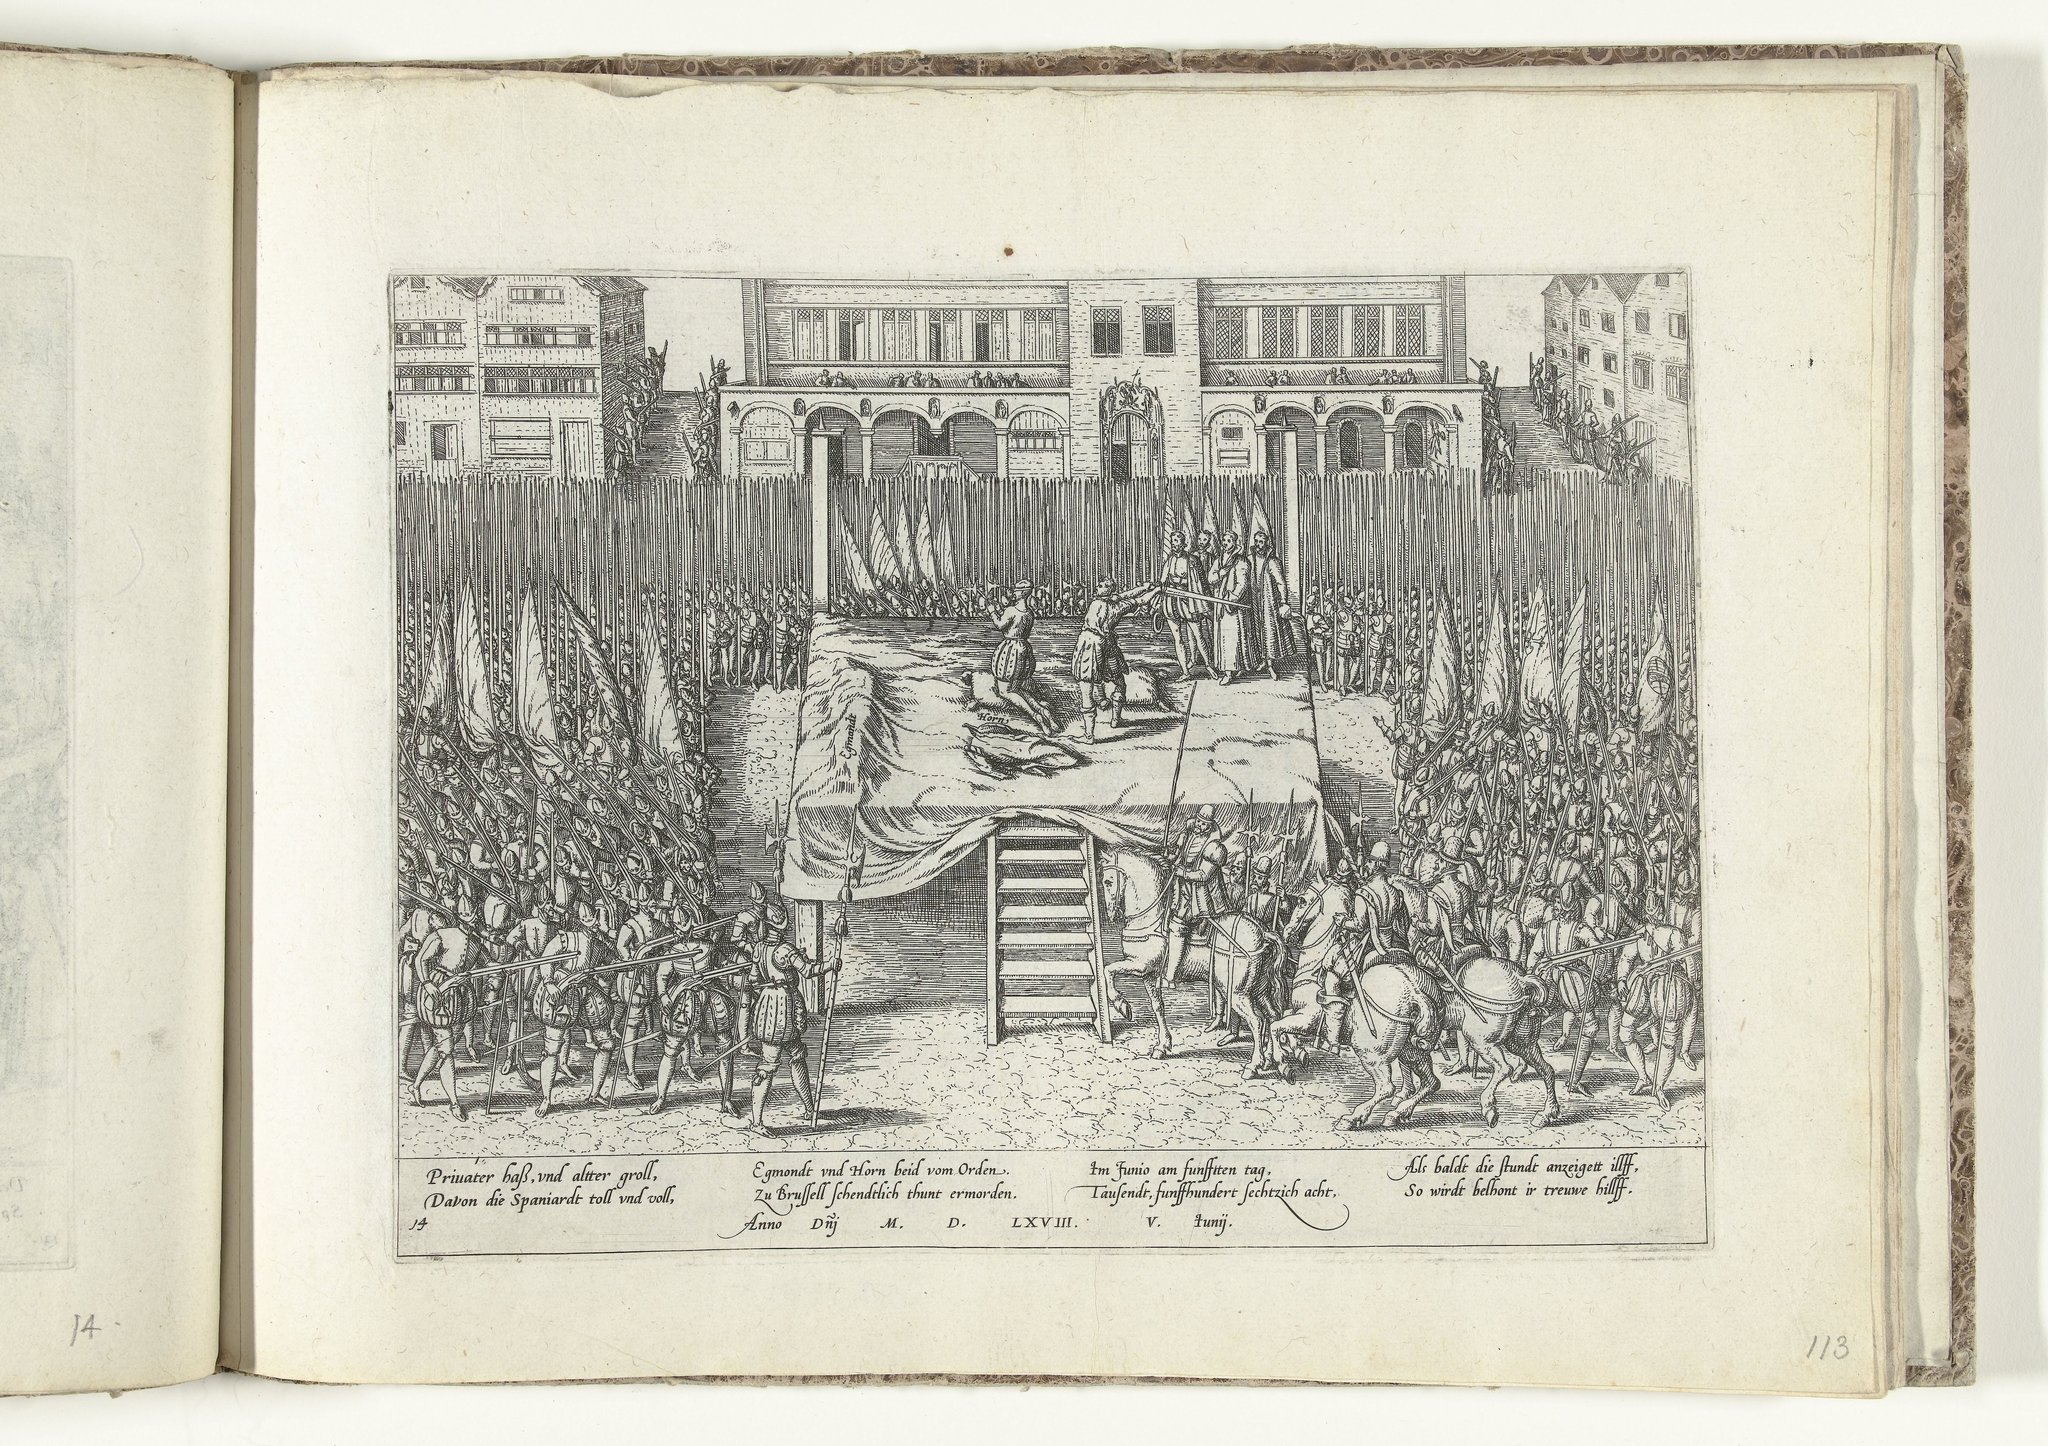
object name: print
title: Onthoofding van Egmond en Horne, 1568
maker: frans hogenberg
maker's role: print maker, publisher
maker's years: 1538-1590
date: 1568-1570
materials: paper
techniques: etching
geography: cologne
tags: fernando álvarez de toledo (3rd duke of alba), brussels, earl, on the scaffold or place of execution, violent death by beheading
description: De onthoofding van Egmond en Horne op de Grote Markt te Brussel, 5 juni 1568. Horne knielt geblinddoekt, het lichaam van Egmond ligt onder een kleed. Terechtstelling op een schavot omgeven door soldaten van Alva. Met onderschrift van 8 regels in het Duits. Genummerd: 14. De prent maakt deel uit van een album.